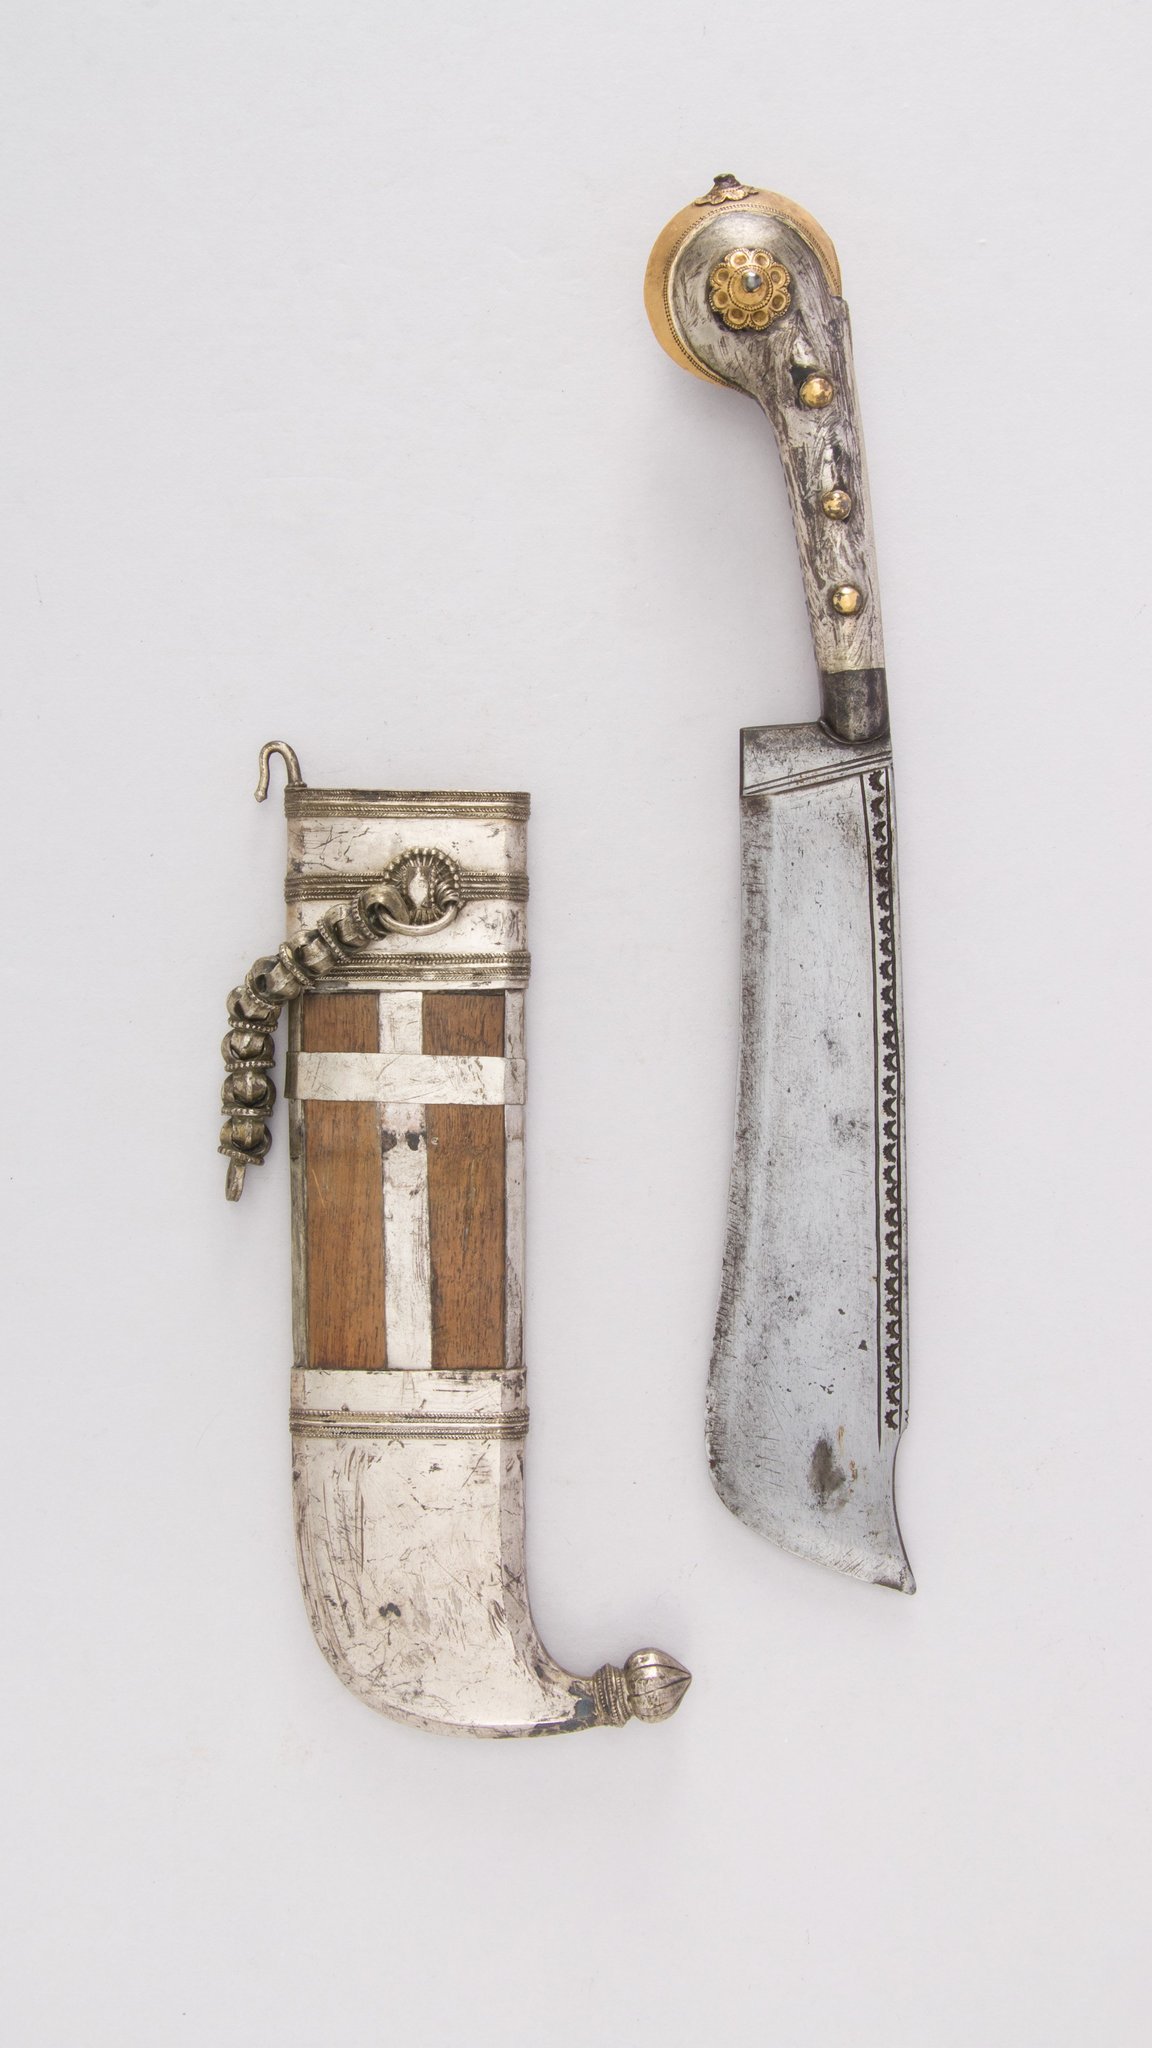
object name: knife pichangatti with sheath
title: Knife (Pichangatti) with Sheath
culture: indian, kodagu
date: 1701-1900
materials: gold, silver, steel, wood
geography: india